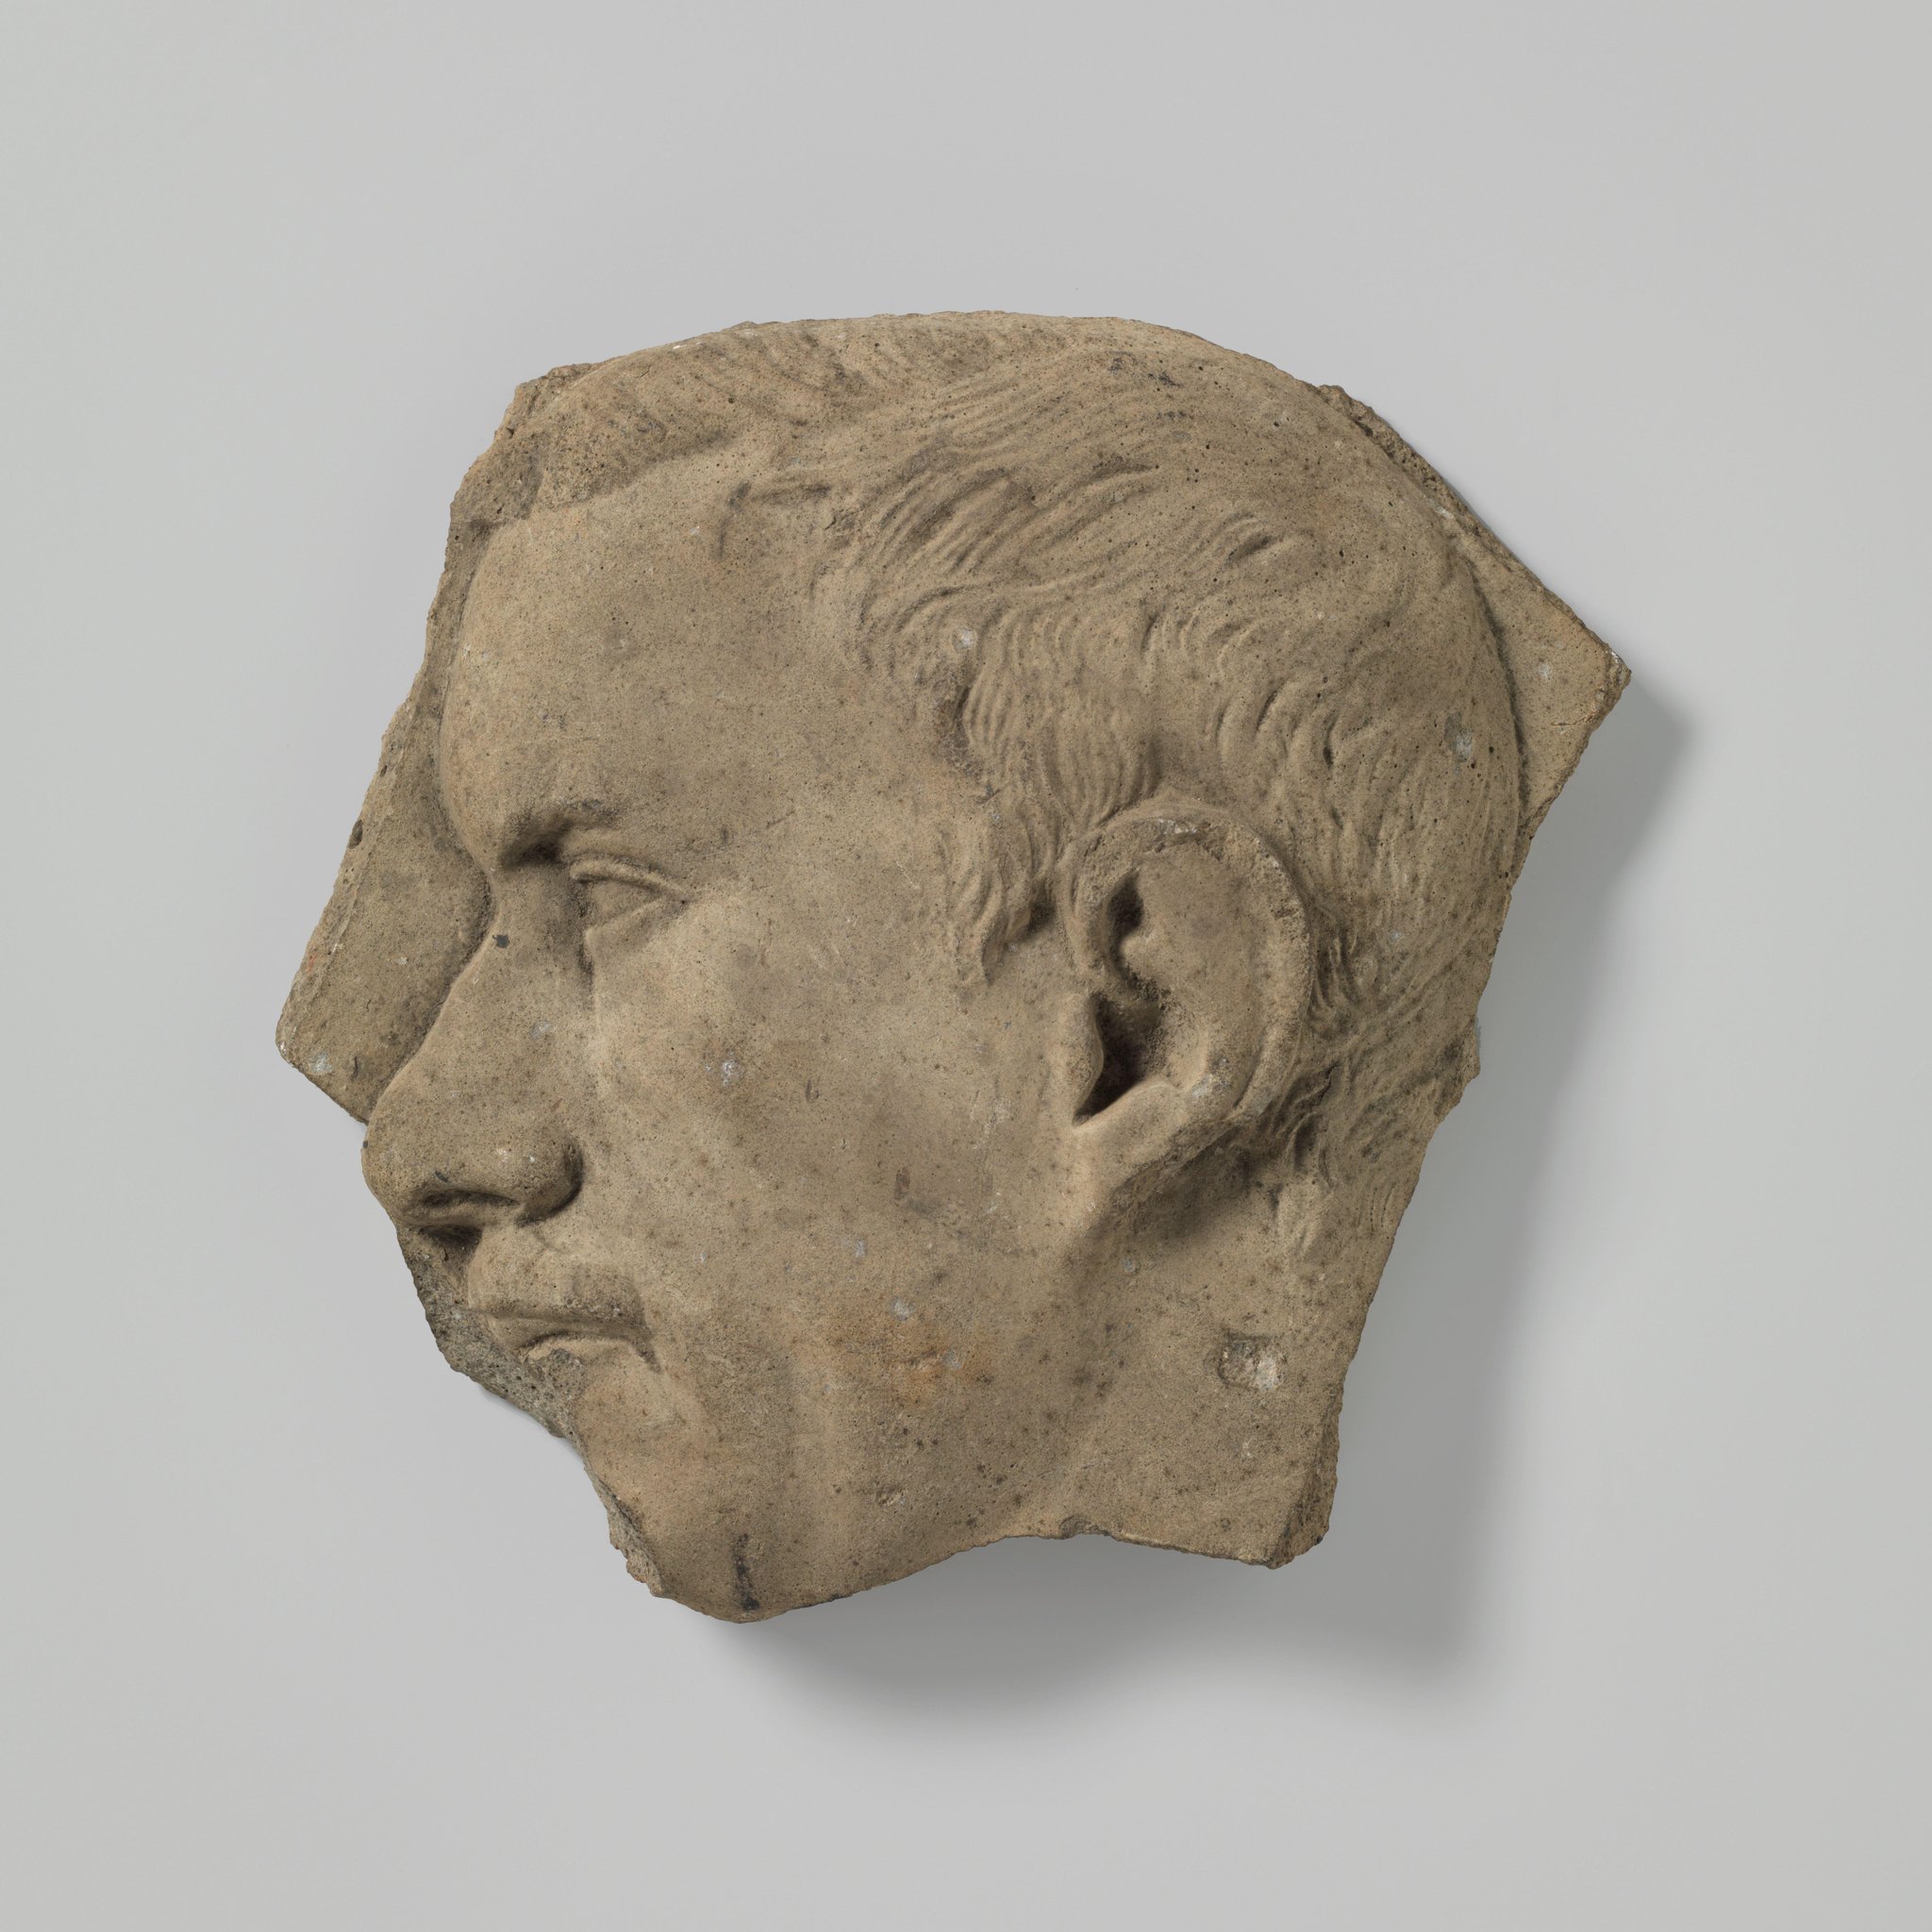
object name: tile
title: Fragment van een tegel met een basreliëf in halfgebrand klei, met een gedeelte van een mannenkop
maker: Anonymous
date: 1600-1800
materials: clay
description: Fragment van een tegel met een basreliëf in halfgebrand klei, met een gedeelte van een mannenkop, kijkend naar links. Mogelijk modern.